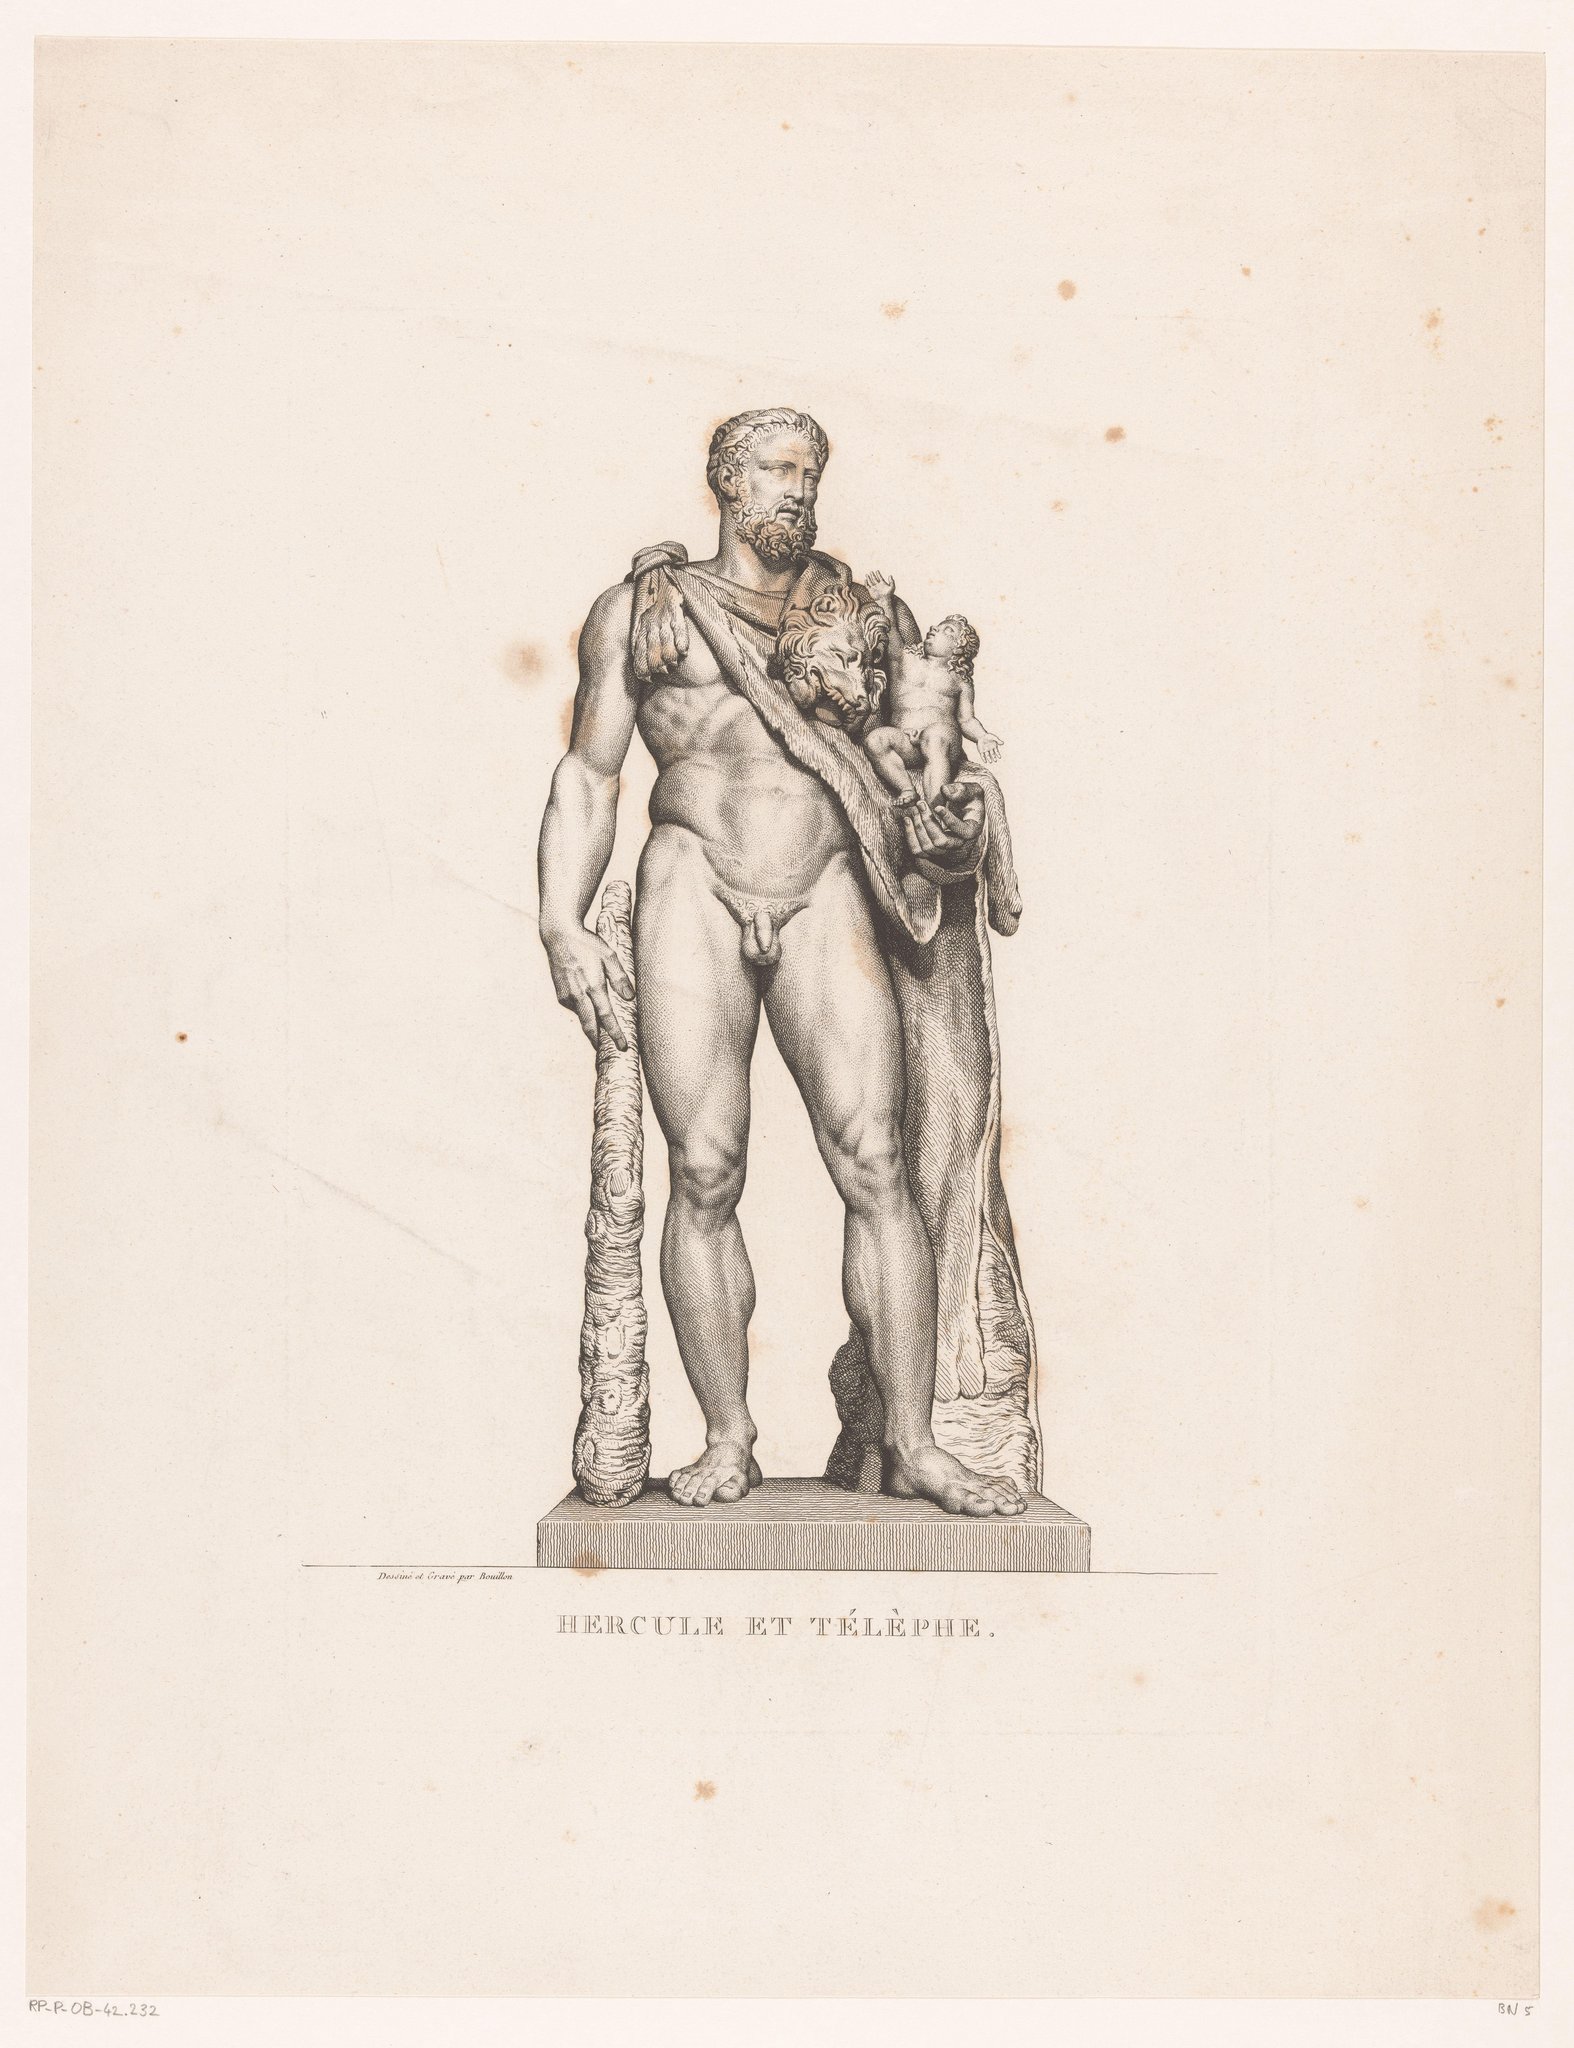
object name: print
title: Hercules en Telephos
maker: pierre bouillon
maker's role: painter, print maker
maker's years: 1776-1831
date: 1820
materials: paper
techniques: engraving, etching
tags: (story of) hercules (heracles), sculpture, telephus is found by hercules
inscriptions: collector's mark: Lugt 2228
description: Maakt deel uit van een serie van 191 prenten, bestaande uit drie delen, uitgegeven door H. Nicolle ca. 1820 te Parijs.